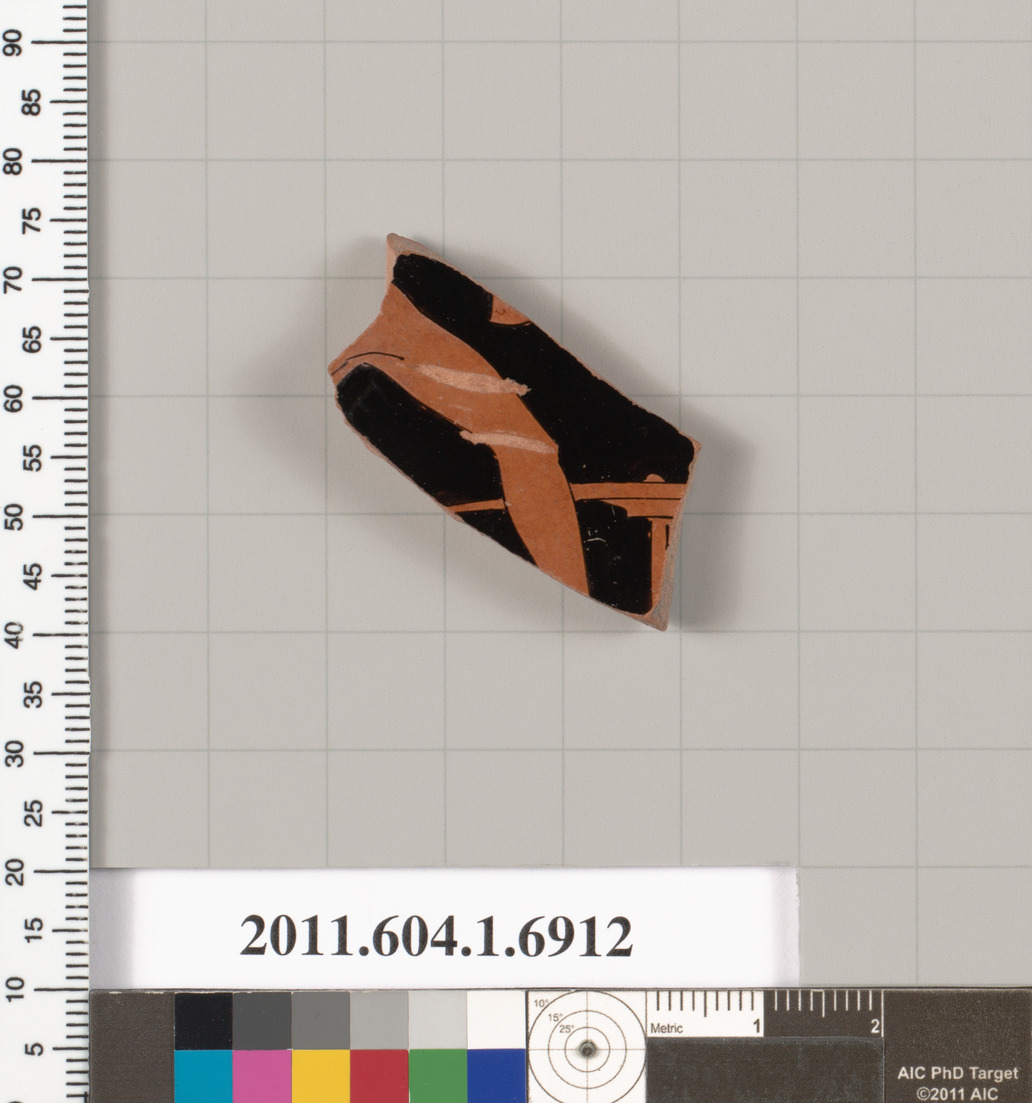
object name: kylix fragment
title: Terracotta fragment of a kylix (drinking cup)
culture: greek, attic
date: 490-470 BCE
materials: terracotta